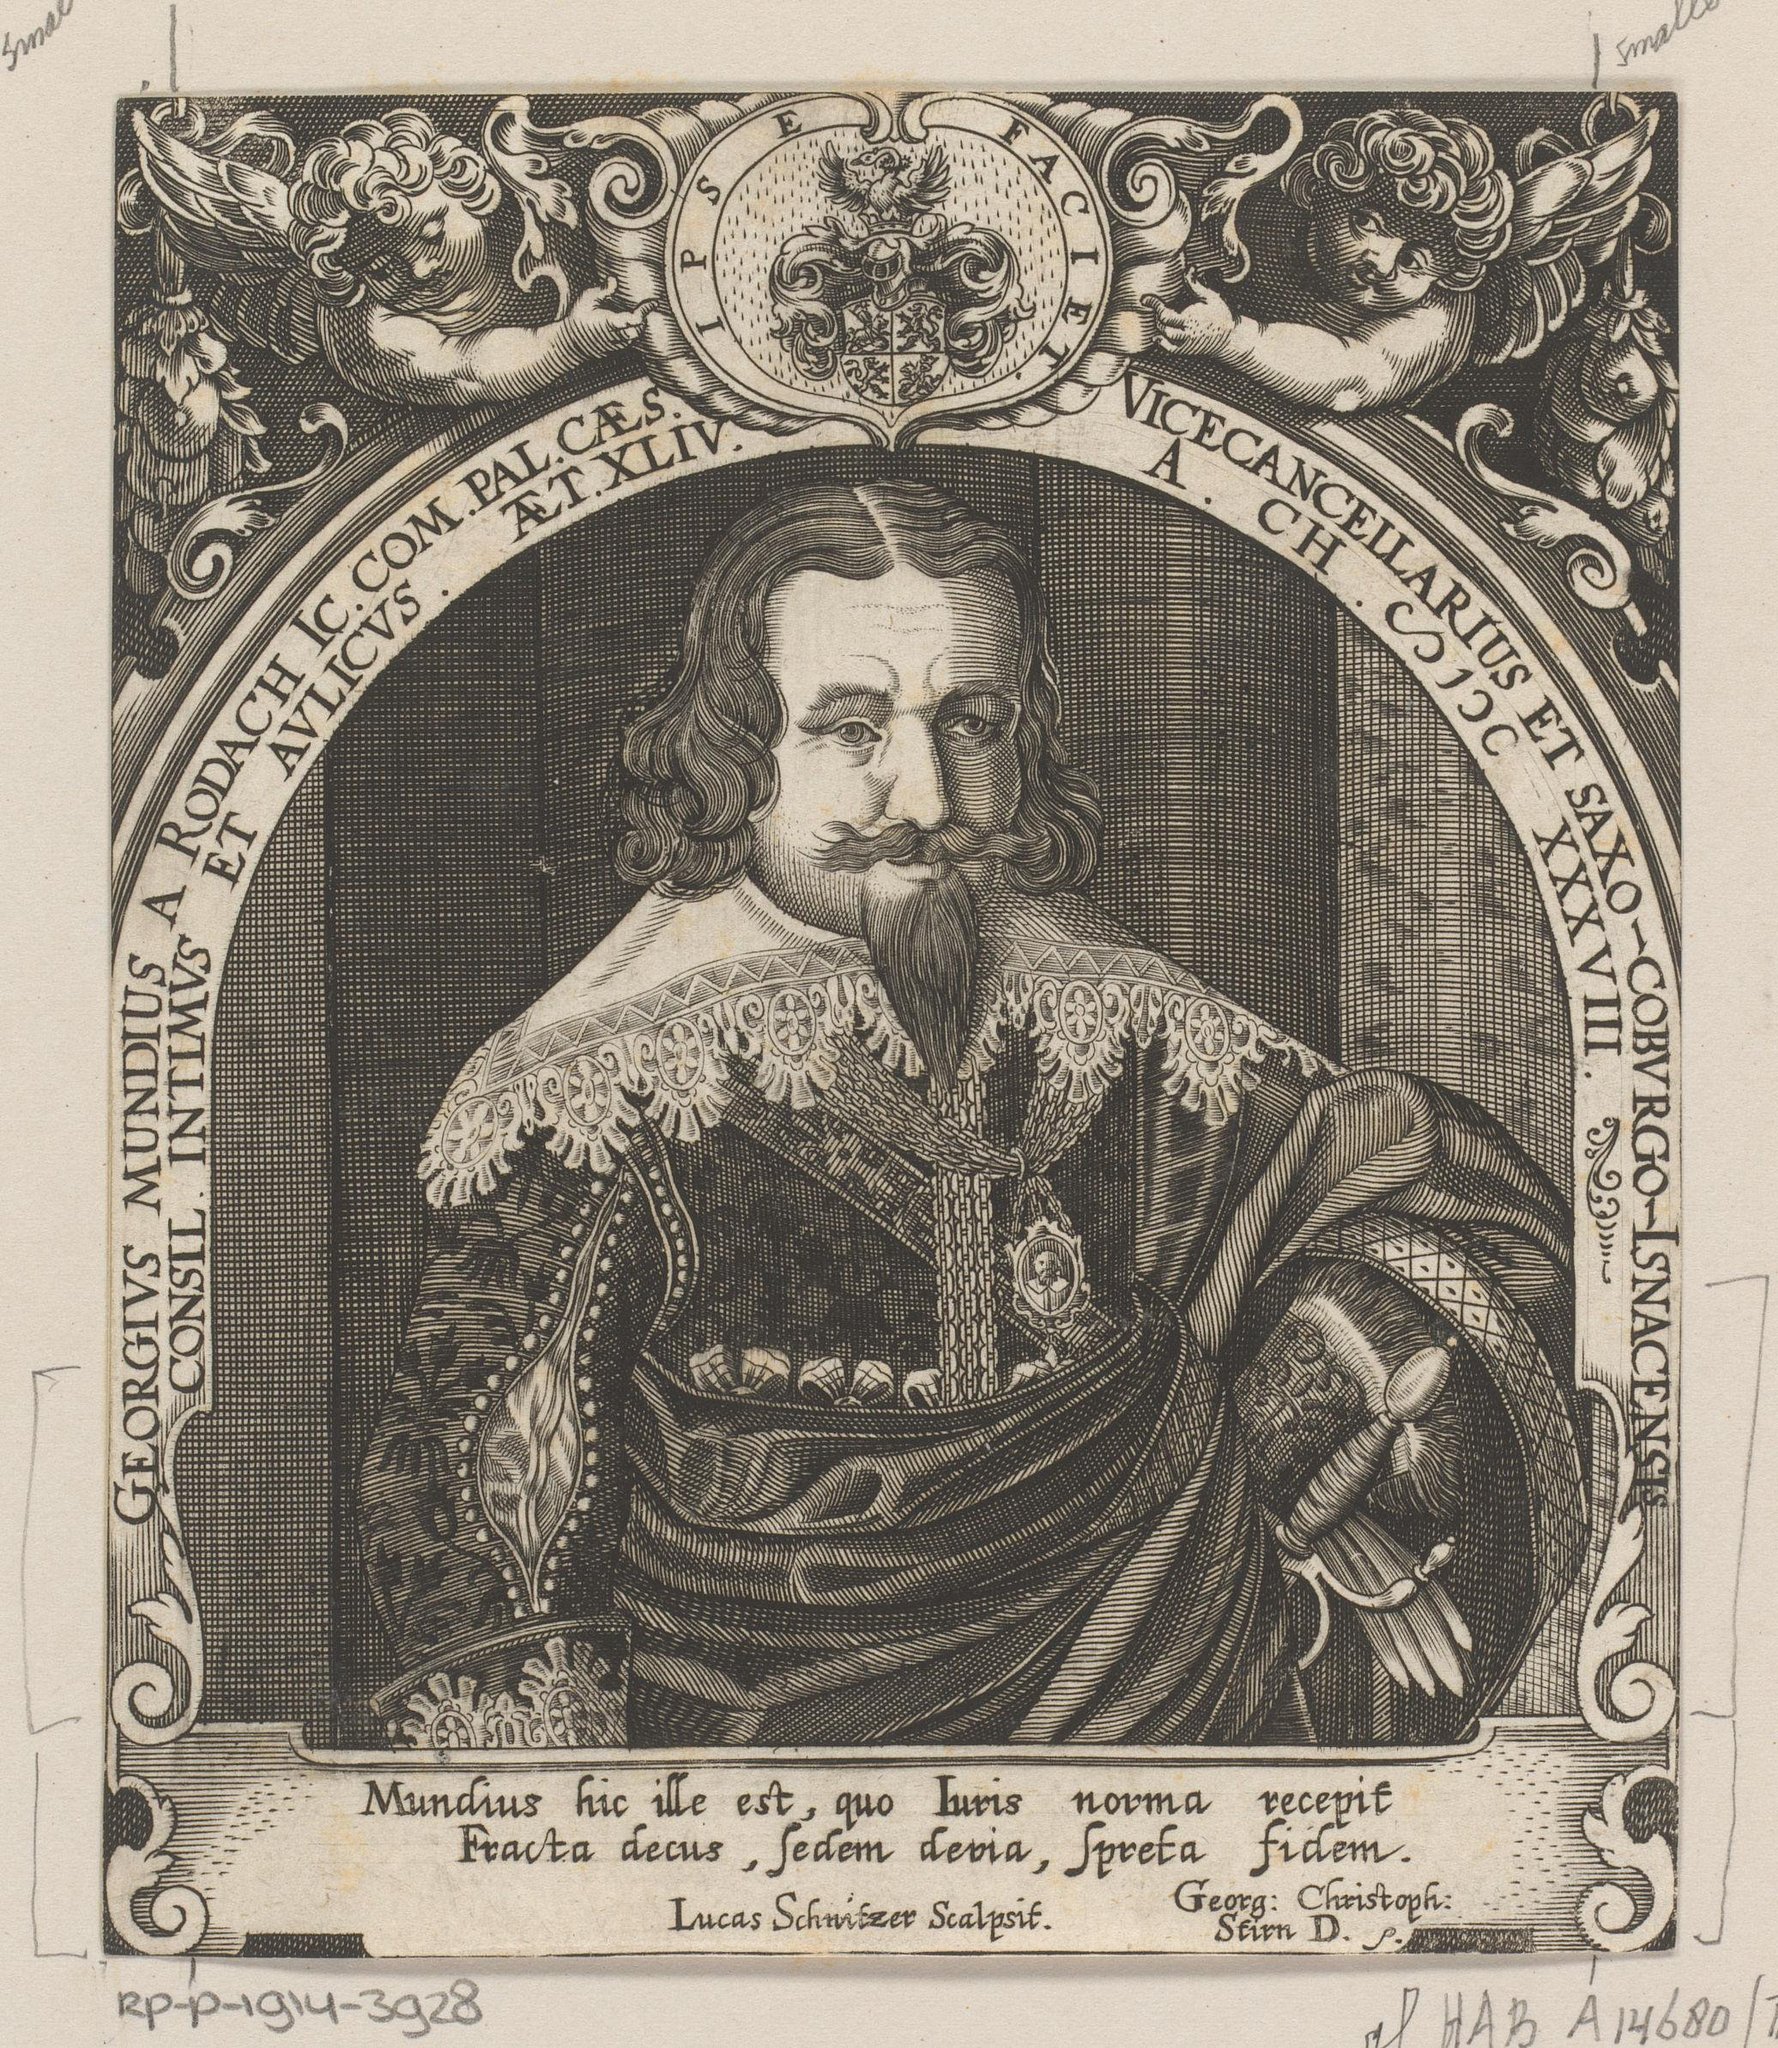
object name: print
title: Georgius Muntus a Rodach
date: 1626-1669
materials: paper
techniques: engraving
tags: georg mundt von rodach, historical persons, armorial bearing, heraldry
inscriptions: collector's mark: Lugt 2228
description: Portret Georg Mund(t) von Rodach, ten halve lijve, van voren gezien, in boogvormige nis. Boven zijn hoofd zijn wapen, vastgehouden door 2 putti. Naam, functie en leeftijd in rand van de nis.